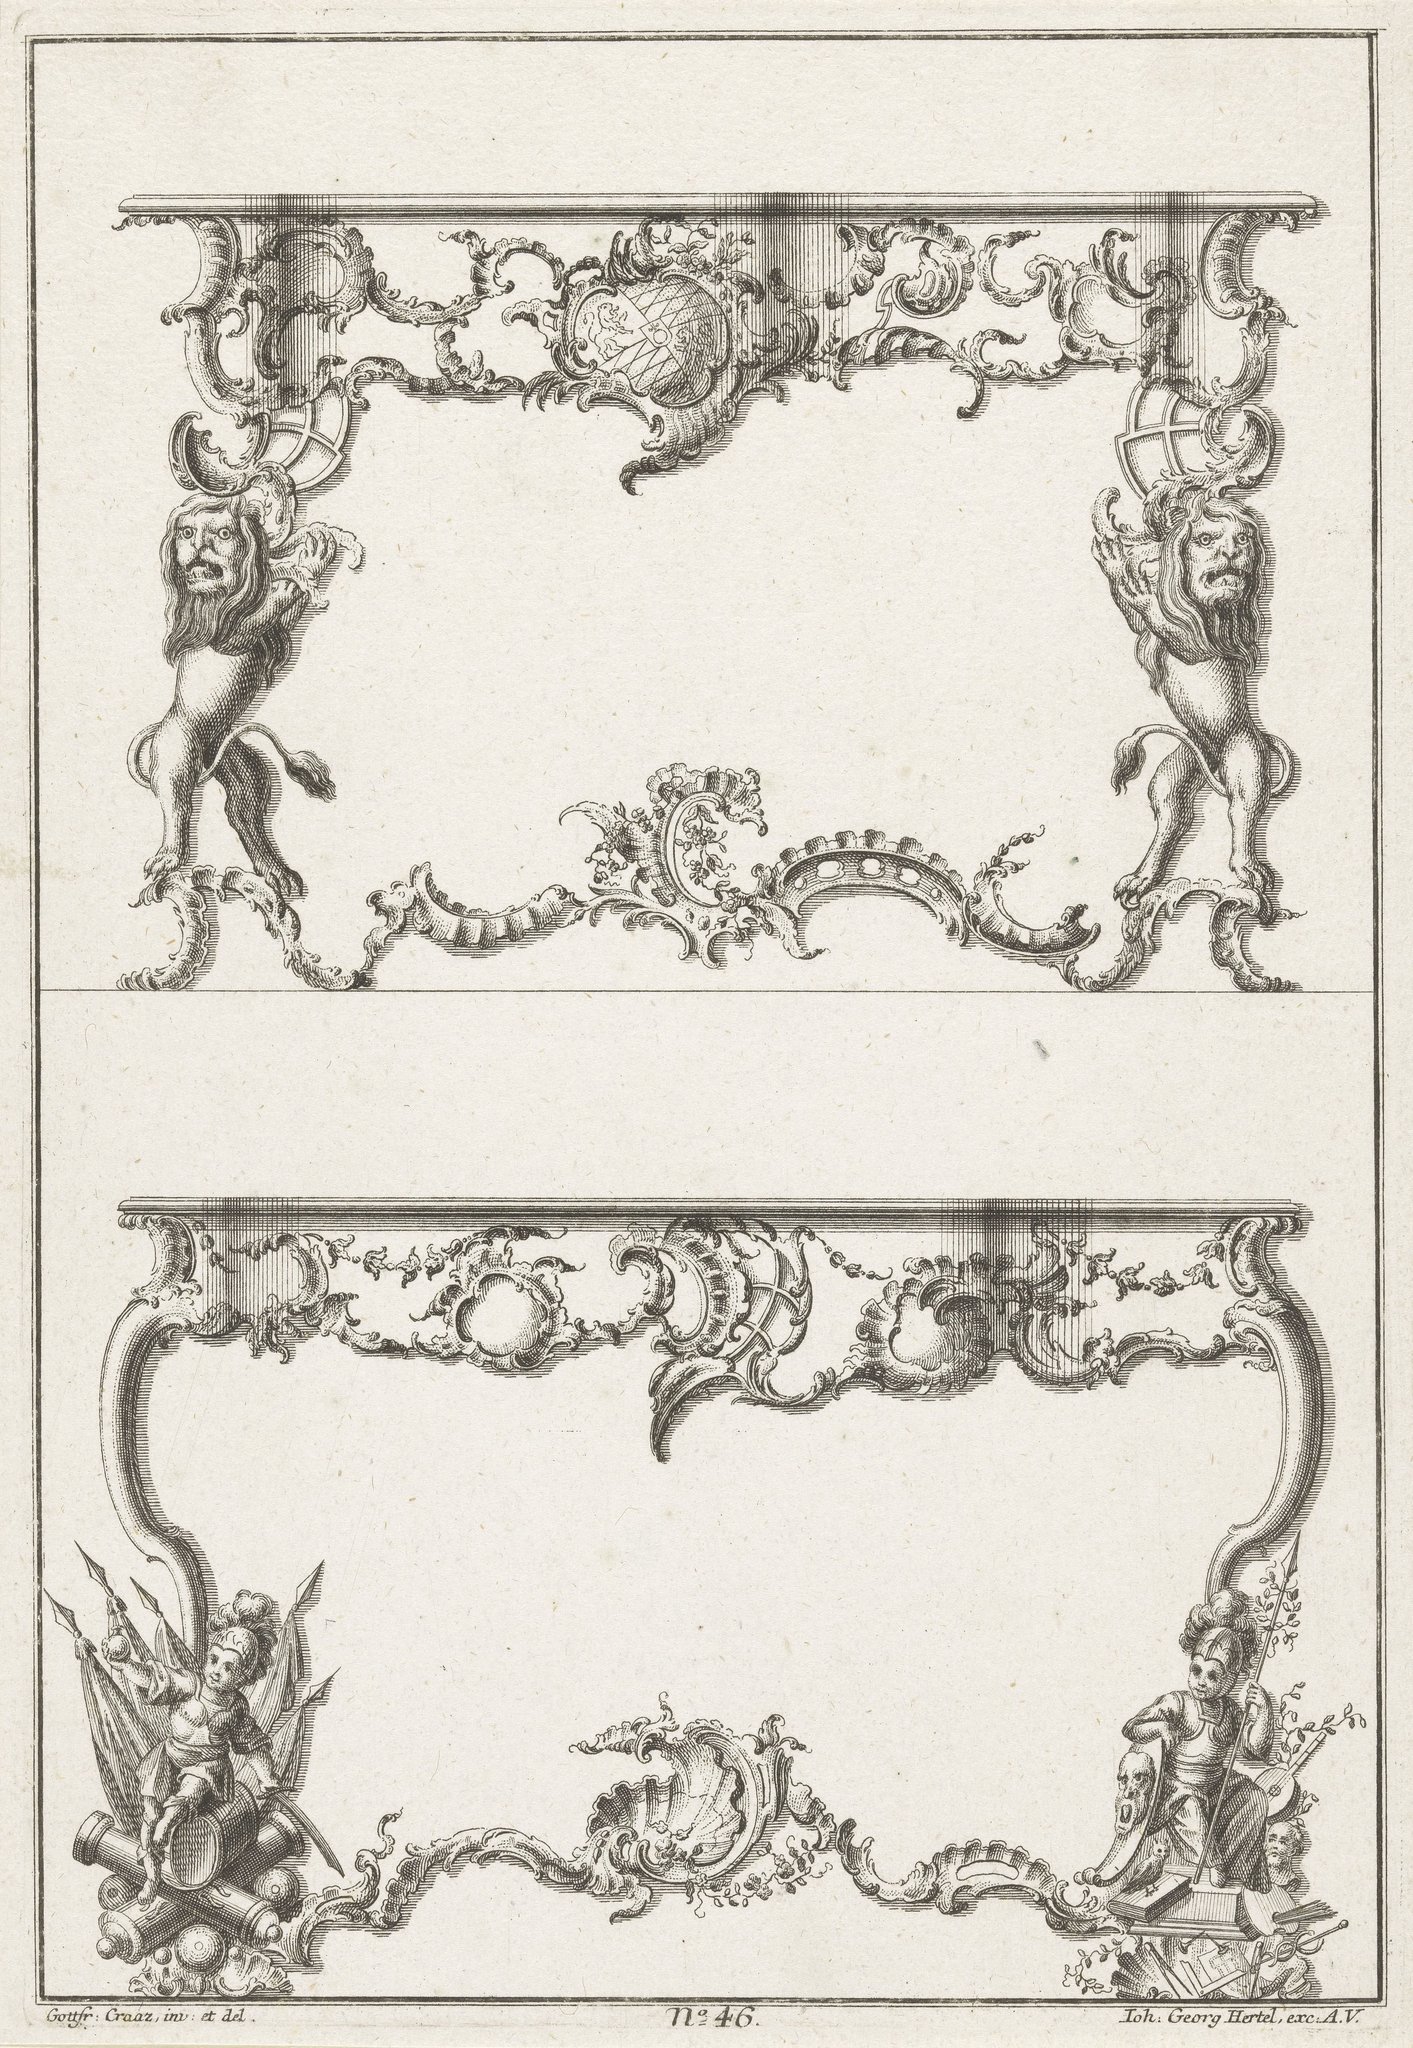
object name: print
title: Divers Tables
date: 1730-1775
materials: paper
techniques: etching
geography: augsburg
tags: rocaille ornament, table, attributes of minerva, attributes of mars, beasts of prey, predatory animals: lion (+ ornamental variants of animals)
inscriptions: collector's mark: Lugt 2228, collector's mark: Lugt 2760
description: De tafels hebben elk een opengewerkte regel en mogelijk twee poten. Het onderstel van de bovenste tafel is versierd met twee leeuwen, rocailles, florale motieven en een wapenschild. Het onderstel van de onderste tafel is versierd met rocailles. Links een putto met de attributen van Mars en rechts een putto met de attributen van Minerva. Midden onder 46 genummerd. Deze prent maakt deel uit van een serie van vier.